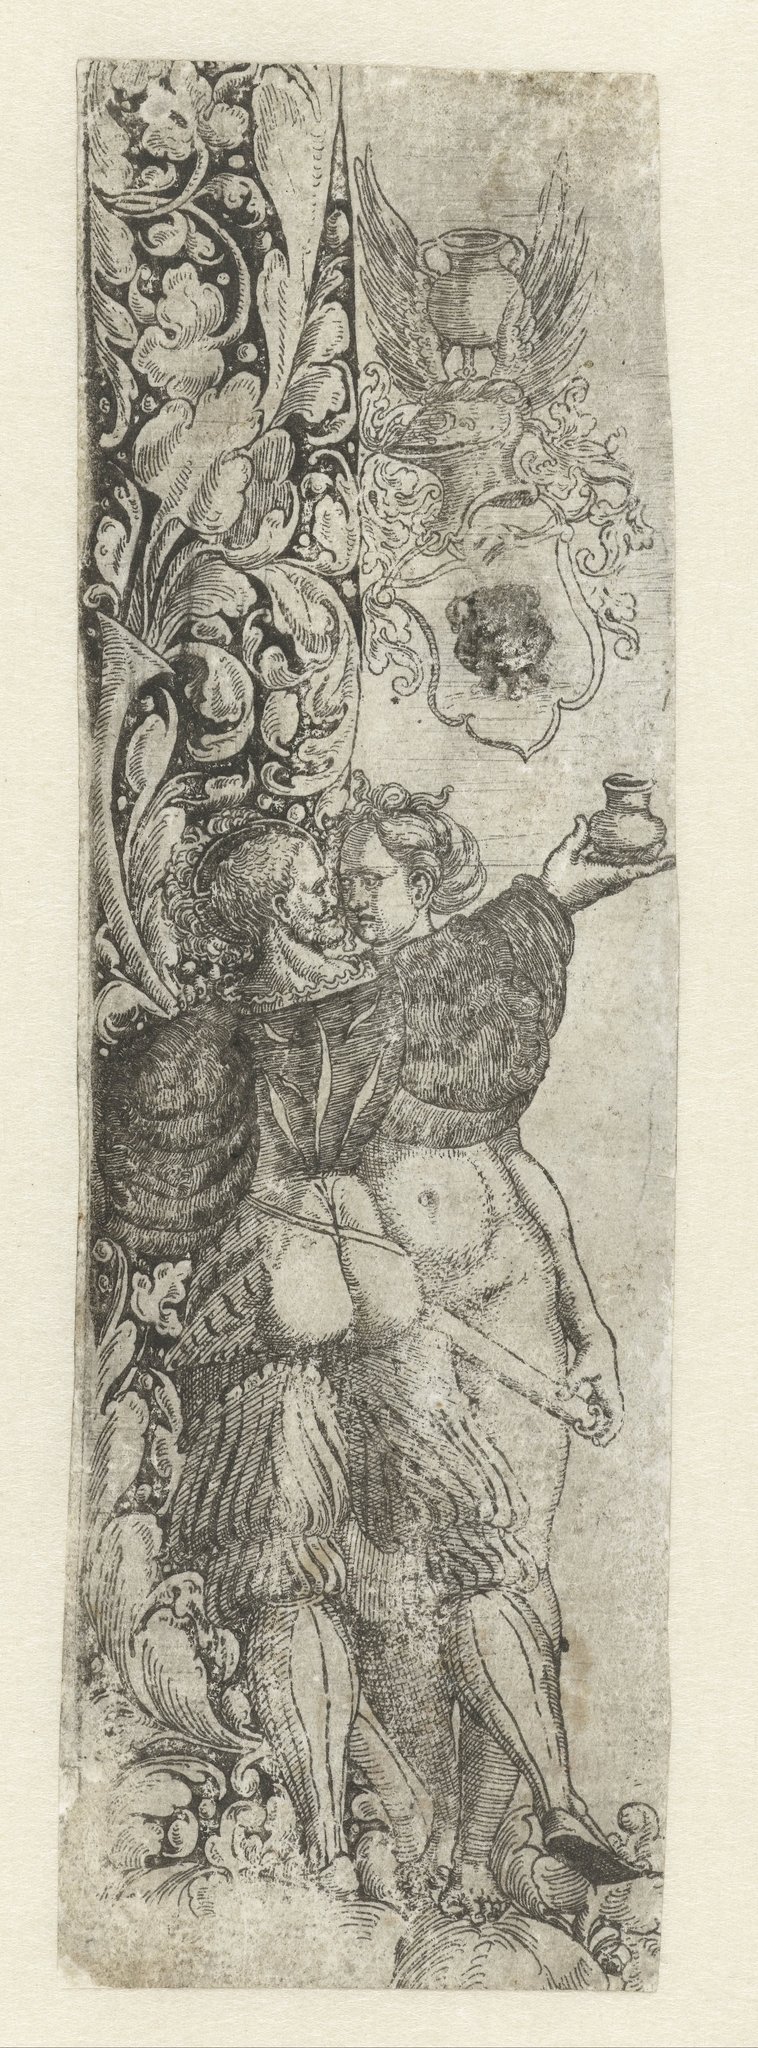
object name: print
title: Soldaat en een jonge naakte vrouw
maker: hans brosamer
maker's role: print maker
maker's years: 1500-1554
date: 1510-1552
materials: paper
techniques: engraving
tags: urban life, private soldier, female sex; woman, foliage, tendrils, branches ~ ornament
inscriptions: collector's mark: Lugt 240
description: Soldaat en een jonge naakte vrouw. De figuren zijn gedeeltelijk opgenomen in een decoratierand met bladmotieven. De man houdt een pot in zijn hand omhoog. Hetzelfde voorwerp, een pot op drie pootjes, is afgebeeld als wapen op een schild. Bovenop de gevleugelde helm van het wapen wordt de pot herhaald.